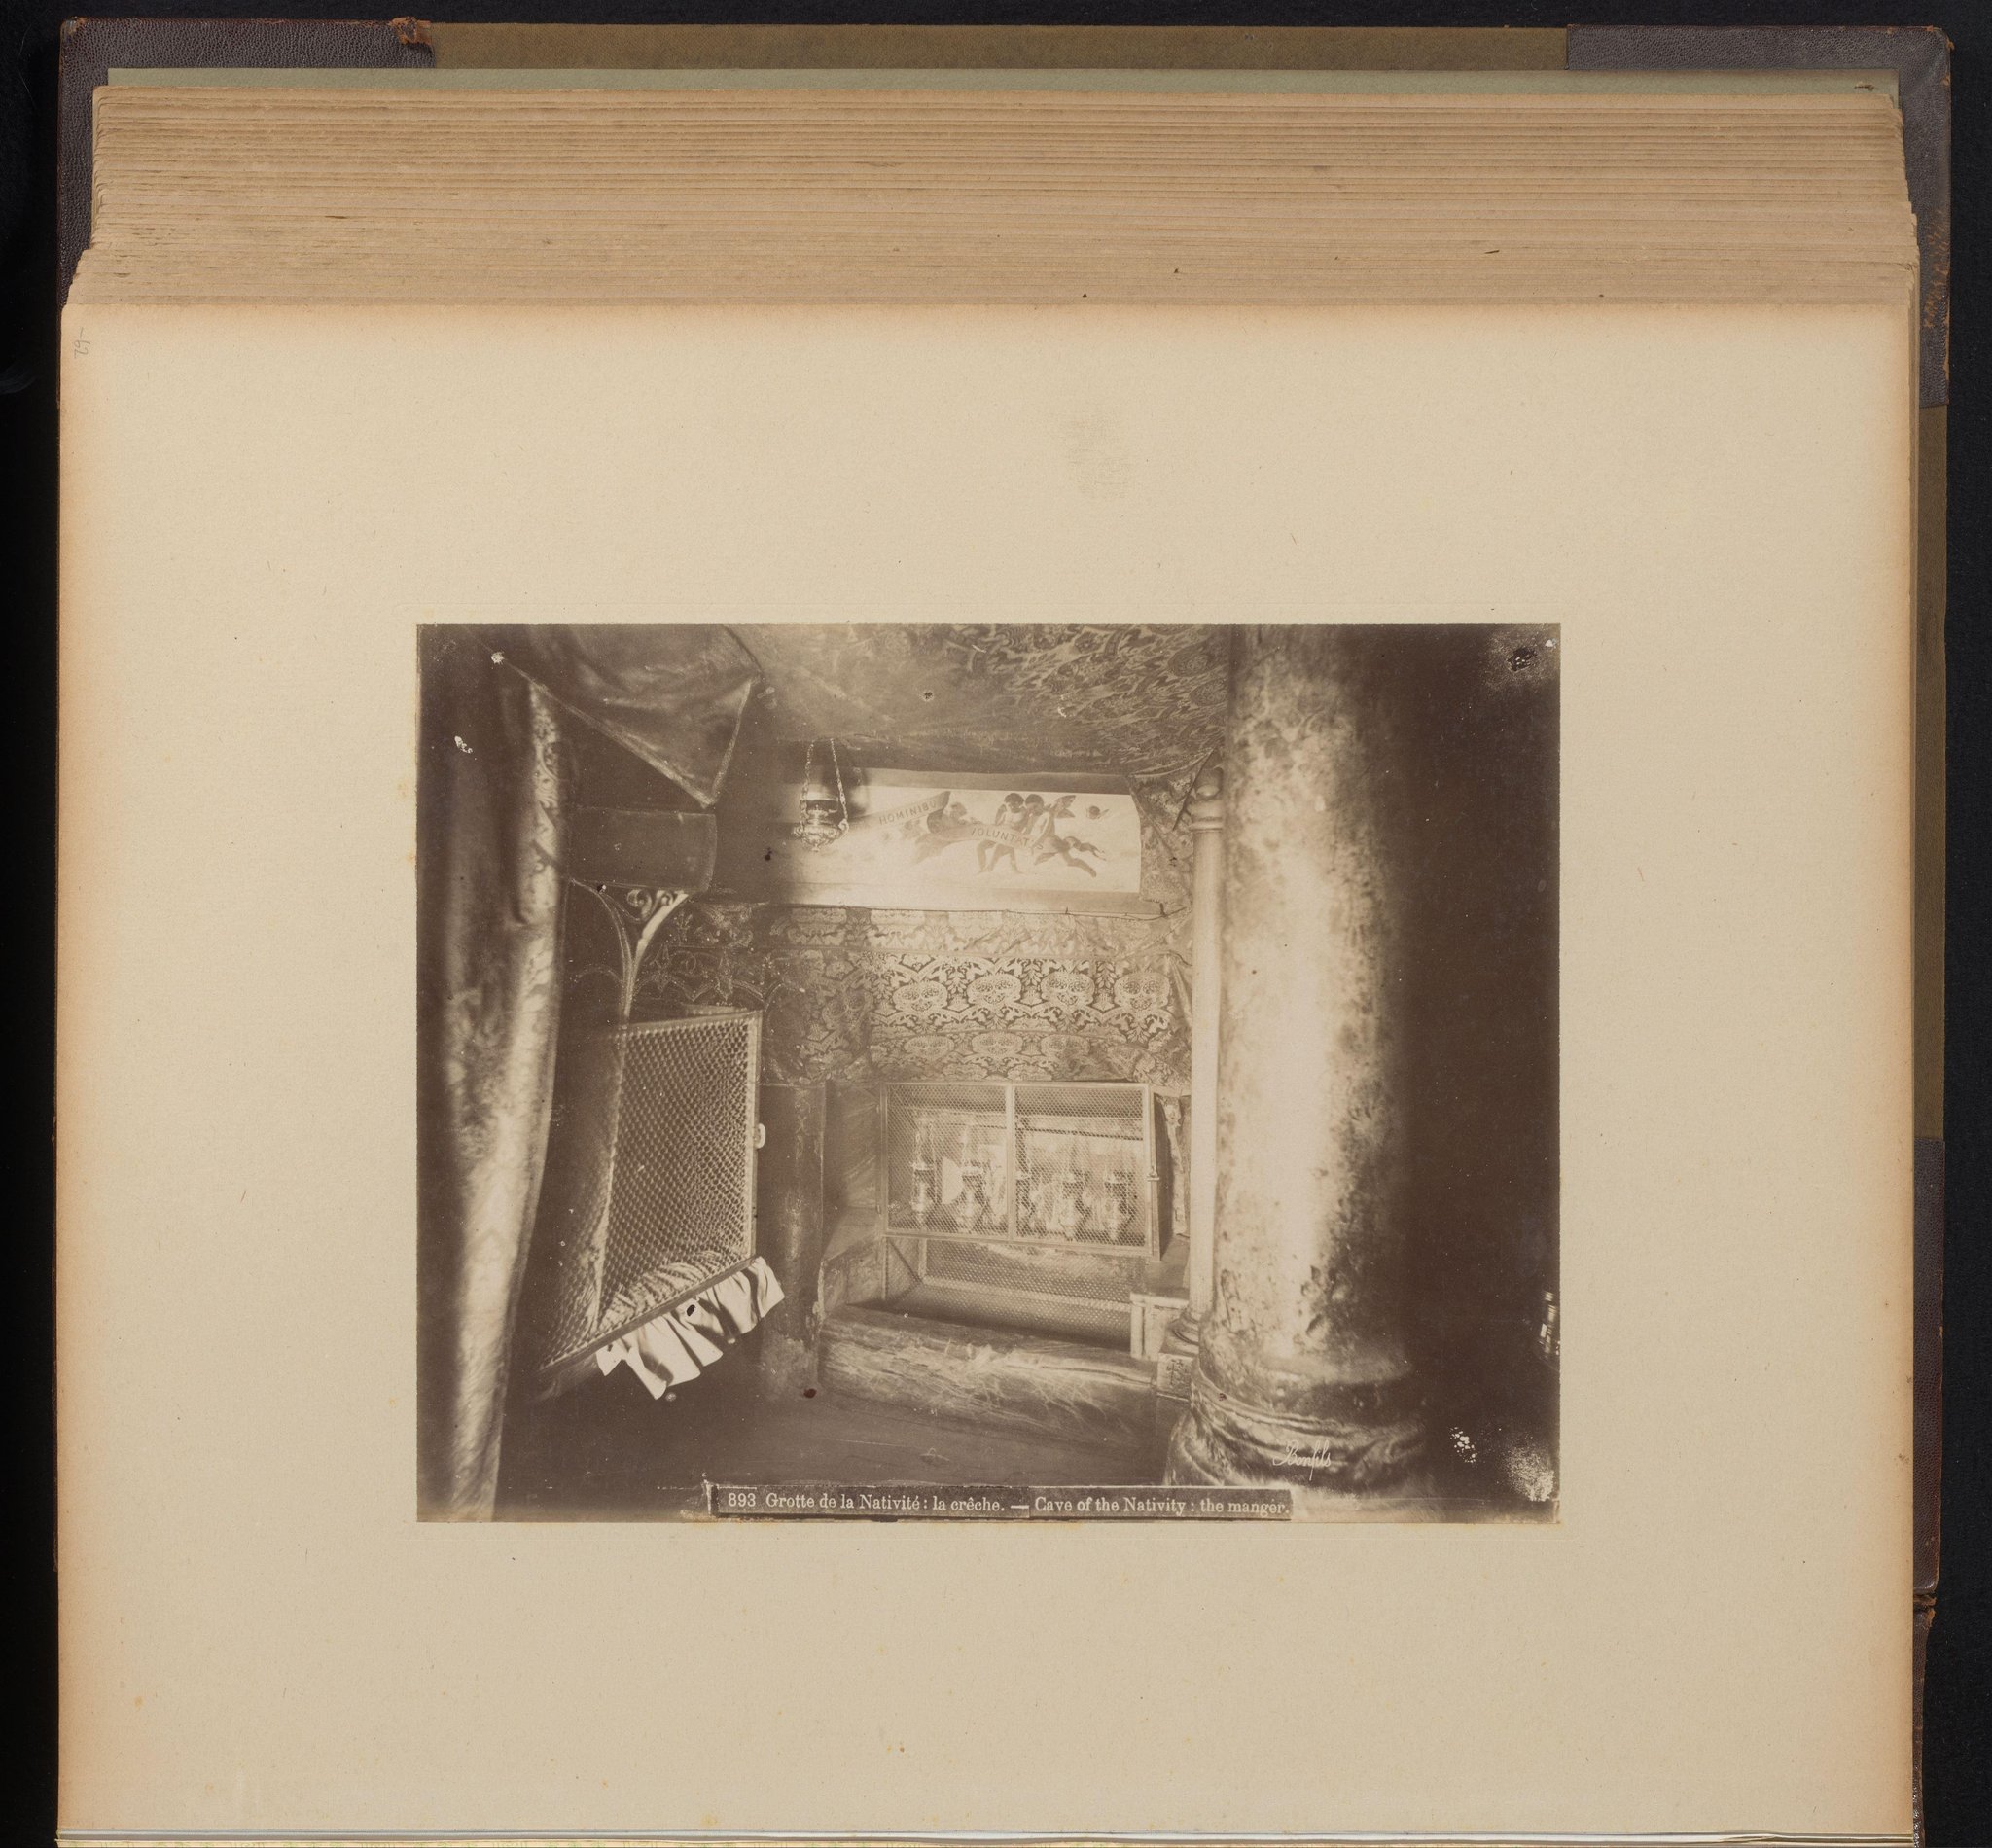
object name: photograph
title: Wieg van Christus in de Geboortekerk in Bethlehem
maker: félix bonfils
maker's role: fotograaf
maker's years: 1831-1885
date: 1867-1885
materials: paper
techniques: albumen print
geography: bethlehem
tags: interior of church, cradle, crib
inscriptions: number: ‘893’